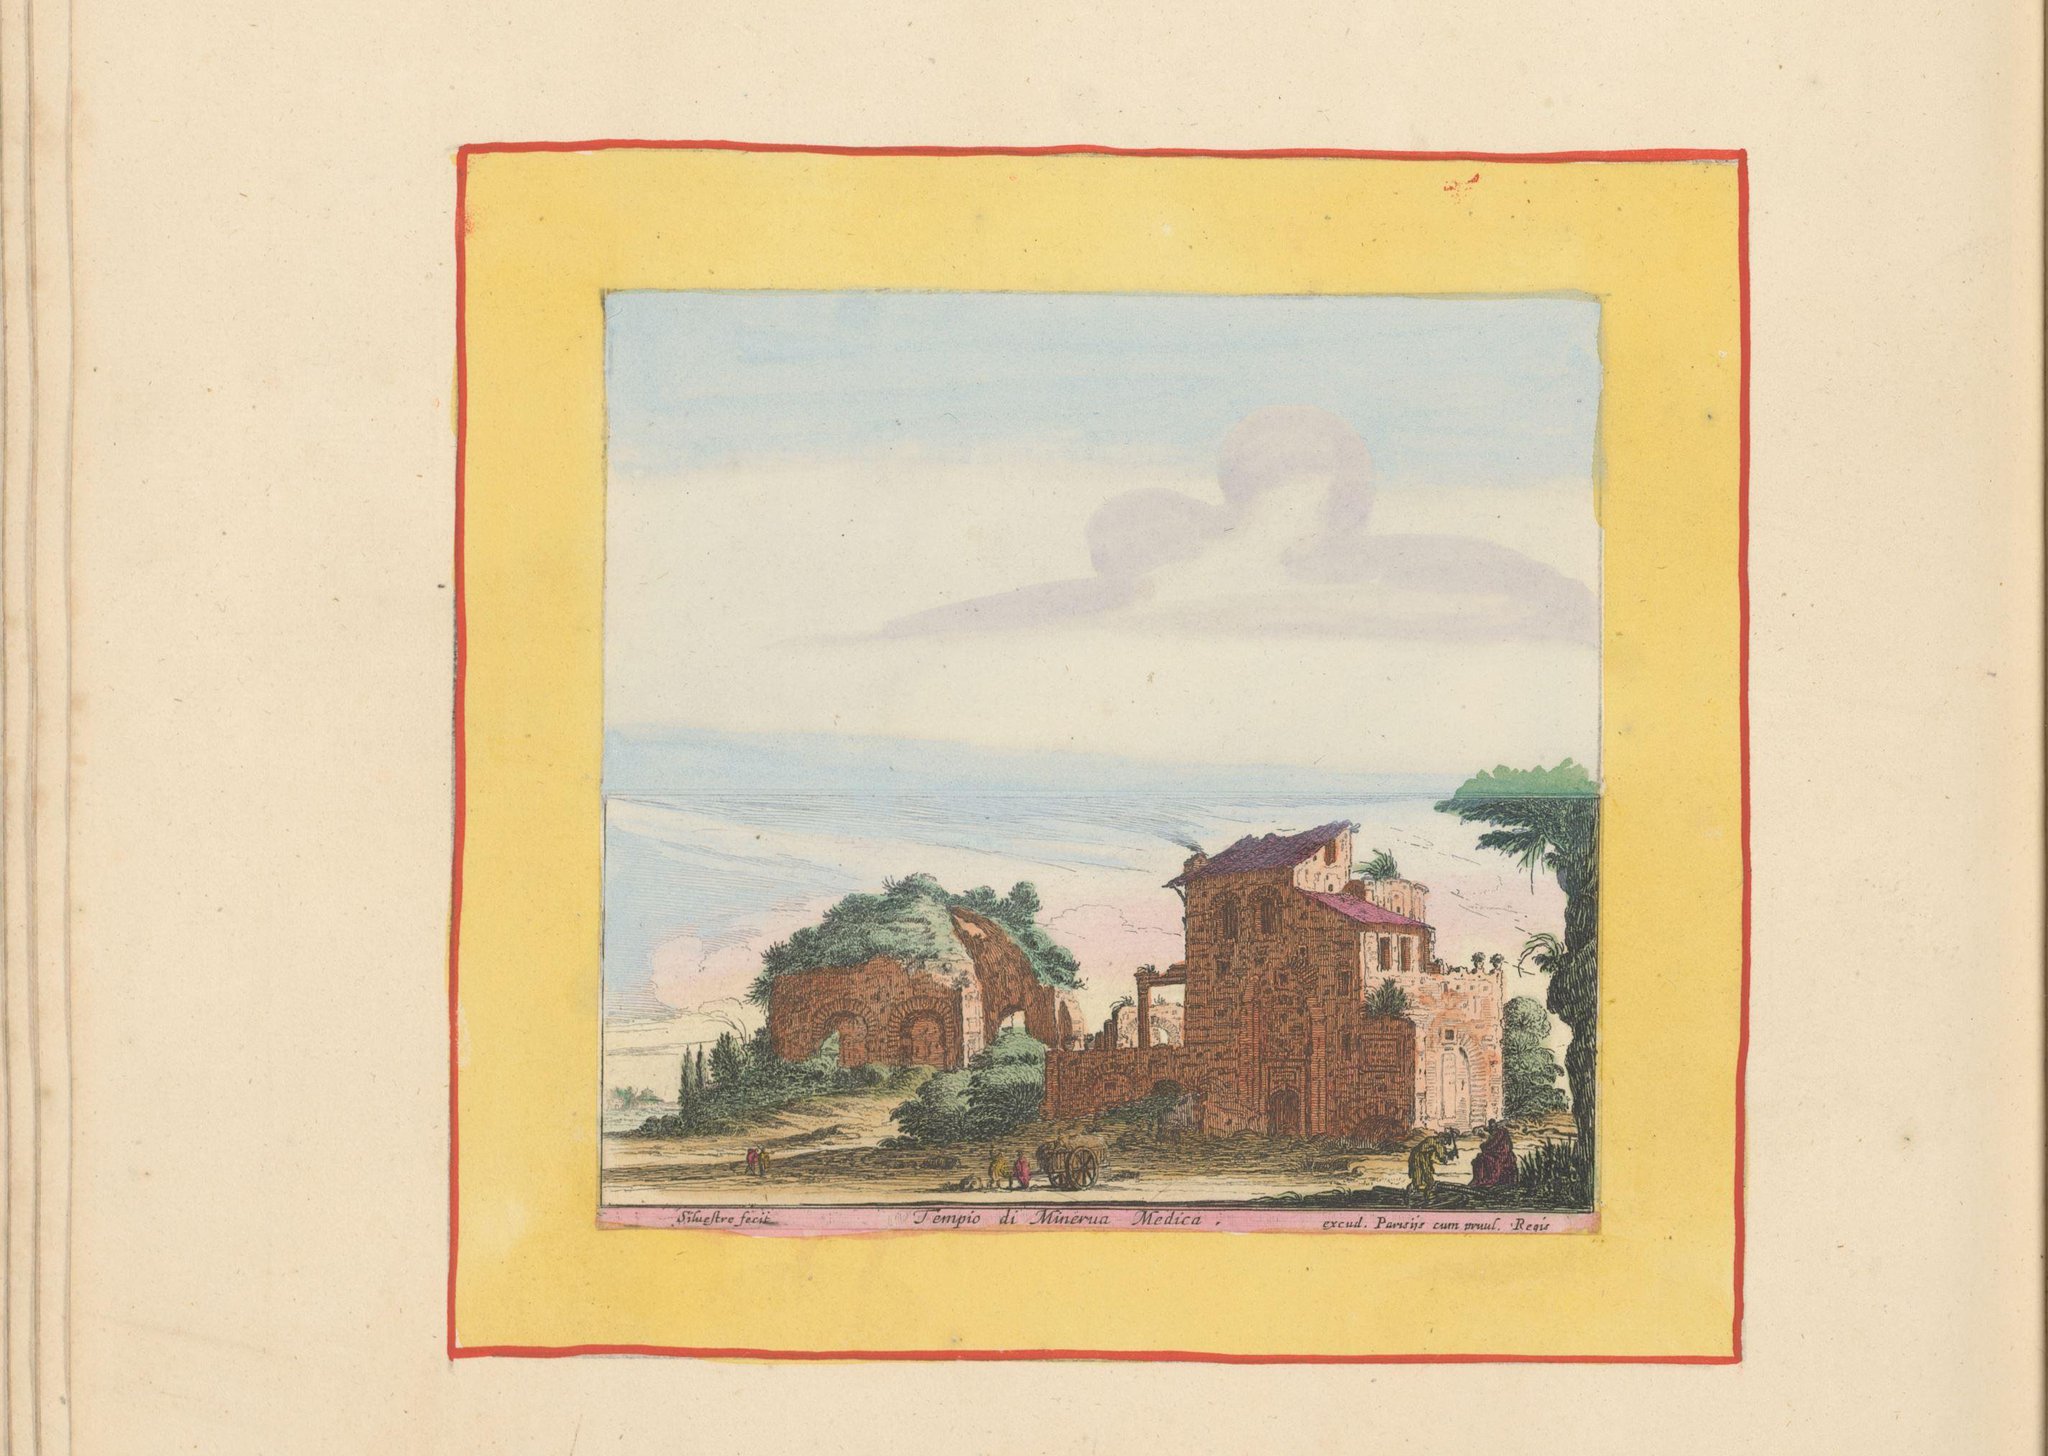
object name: album leaf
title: Antieke en moderne monumenten in Rome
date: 1631-1691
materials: paper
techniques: colour, etching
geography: paris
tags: city-view, and landscape with man-made constructions, landscape with ruins, temple, shrine ~ roman religion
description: Prent maakt deel uit van een reeks van twaalf prenten van gezichten op antieke en moderne monumenten in Rome. De prent is langs de bovenrand van de voorstelling afgescheurd. De voorstelling is aan de bovenzijde aangevuld met een geschilderde lucht.